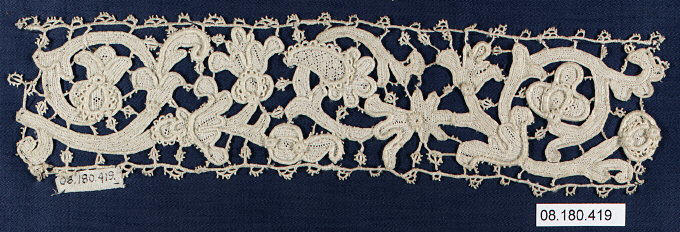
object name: fragment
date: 1801-1900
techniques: lace